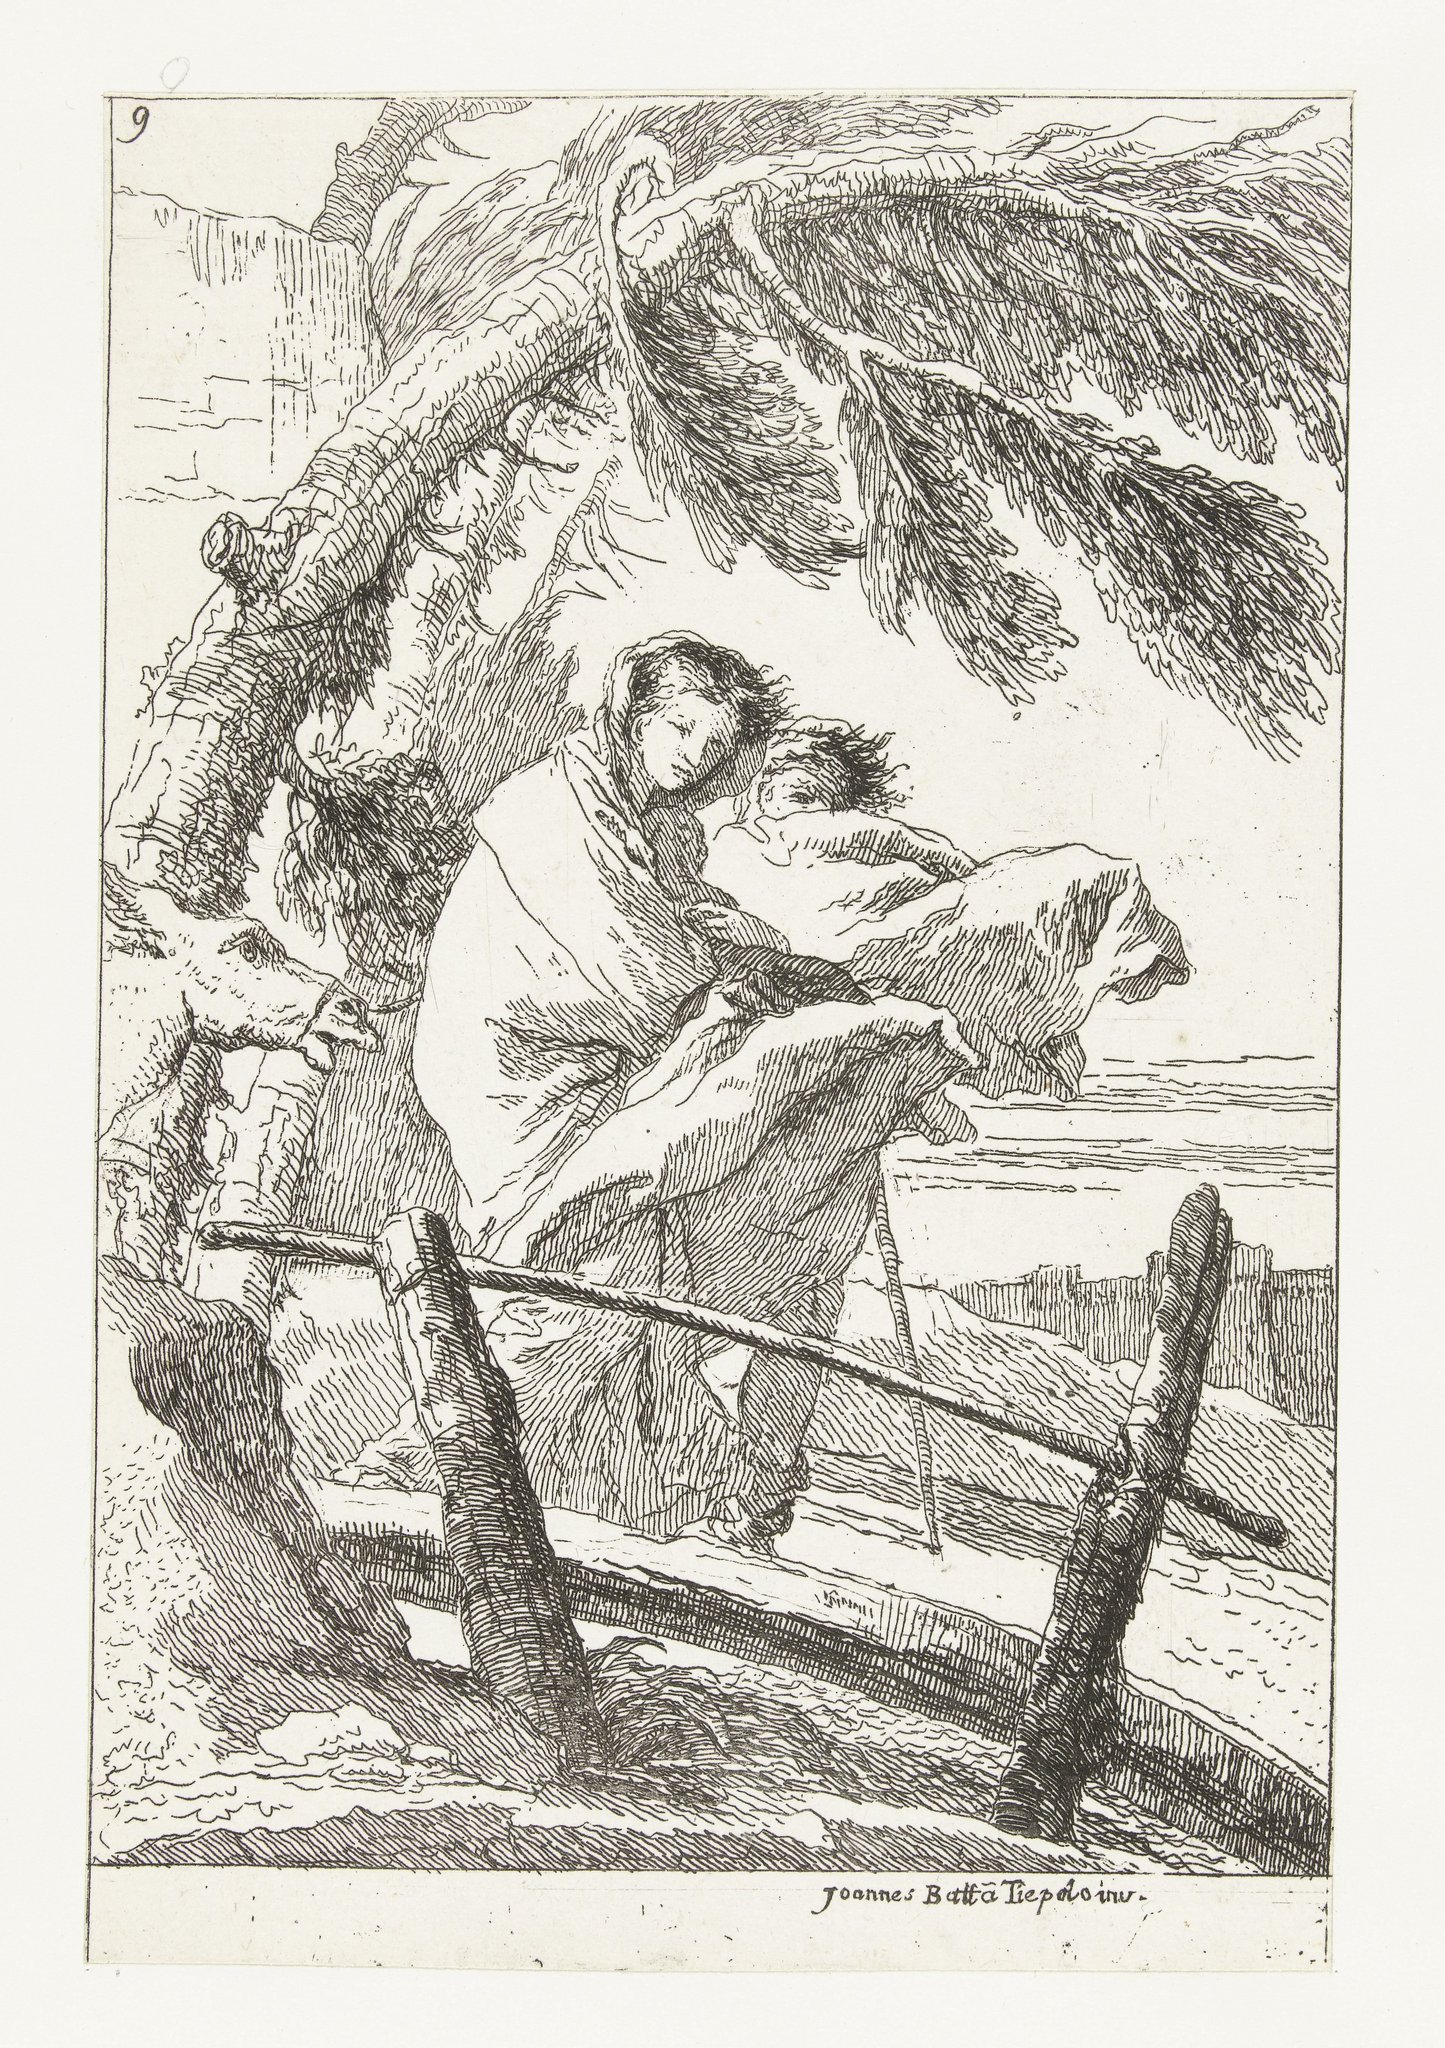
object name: print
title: Heilige familie loopt over kleine brug tijdens vlucht naar Egypte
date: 1748-1752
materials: paper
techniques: etching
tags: flight into egypt and miracles during the journey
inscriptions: collector's mark: Lugt 2228, collector's mark: Lugt 2760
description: Prent naar ontwerp van Giovanni Battista Tiepolo. Prent maakt deel uit van blad met twee scènes uit het bijbelverhaal van de Vlucht naar Egypte. In de collectie van het RMA zijn de twee prenten losgesneden (vergelijk inv.nr. RP-P-1950-491).